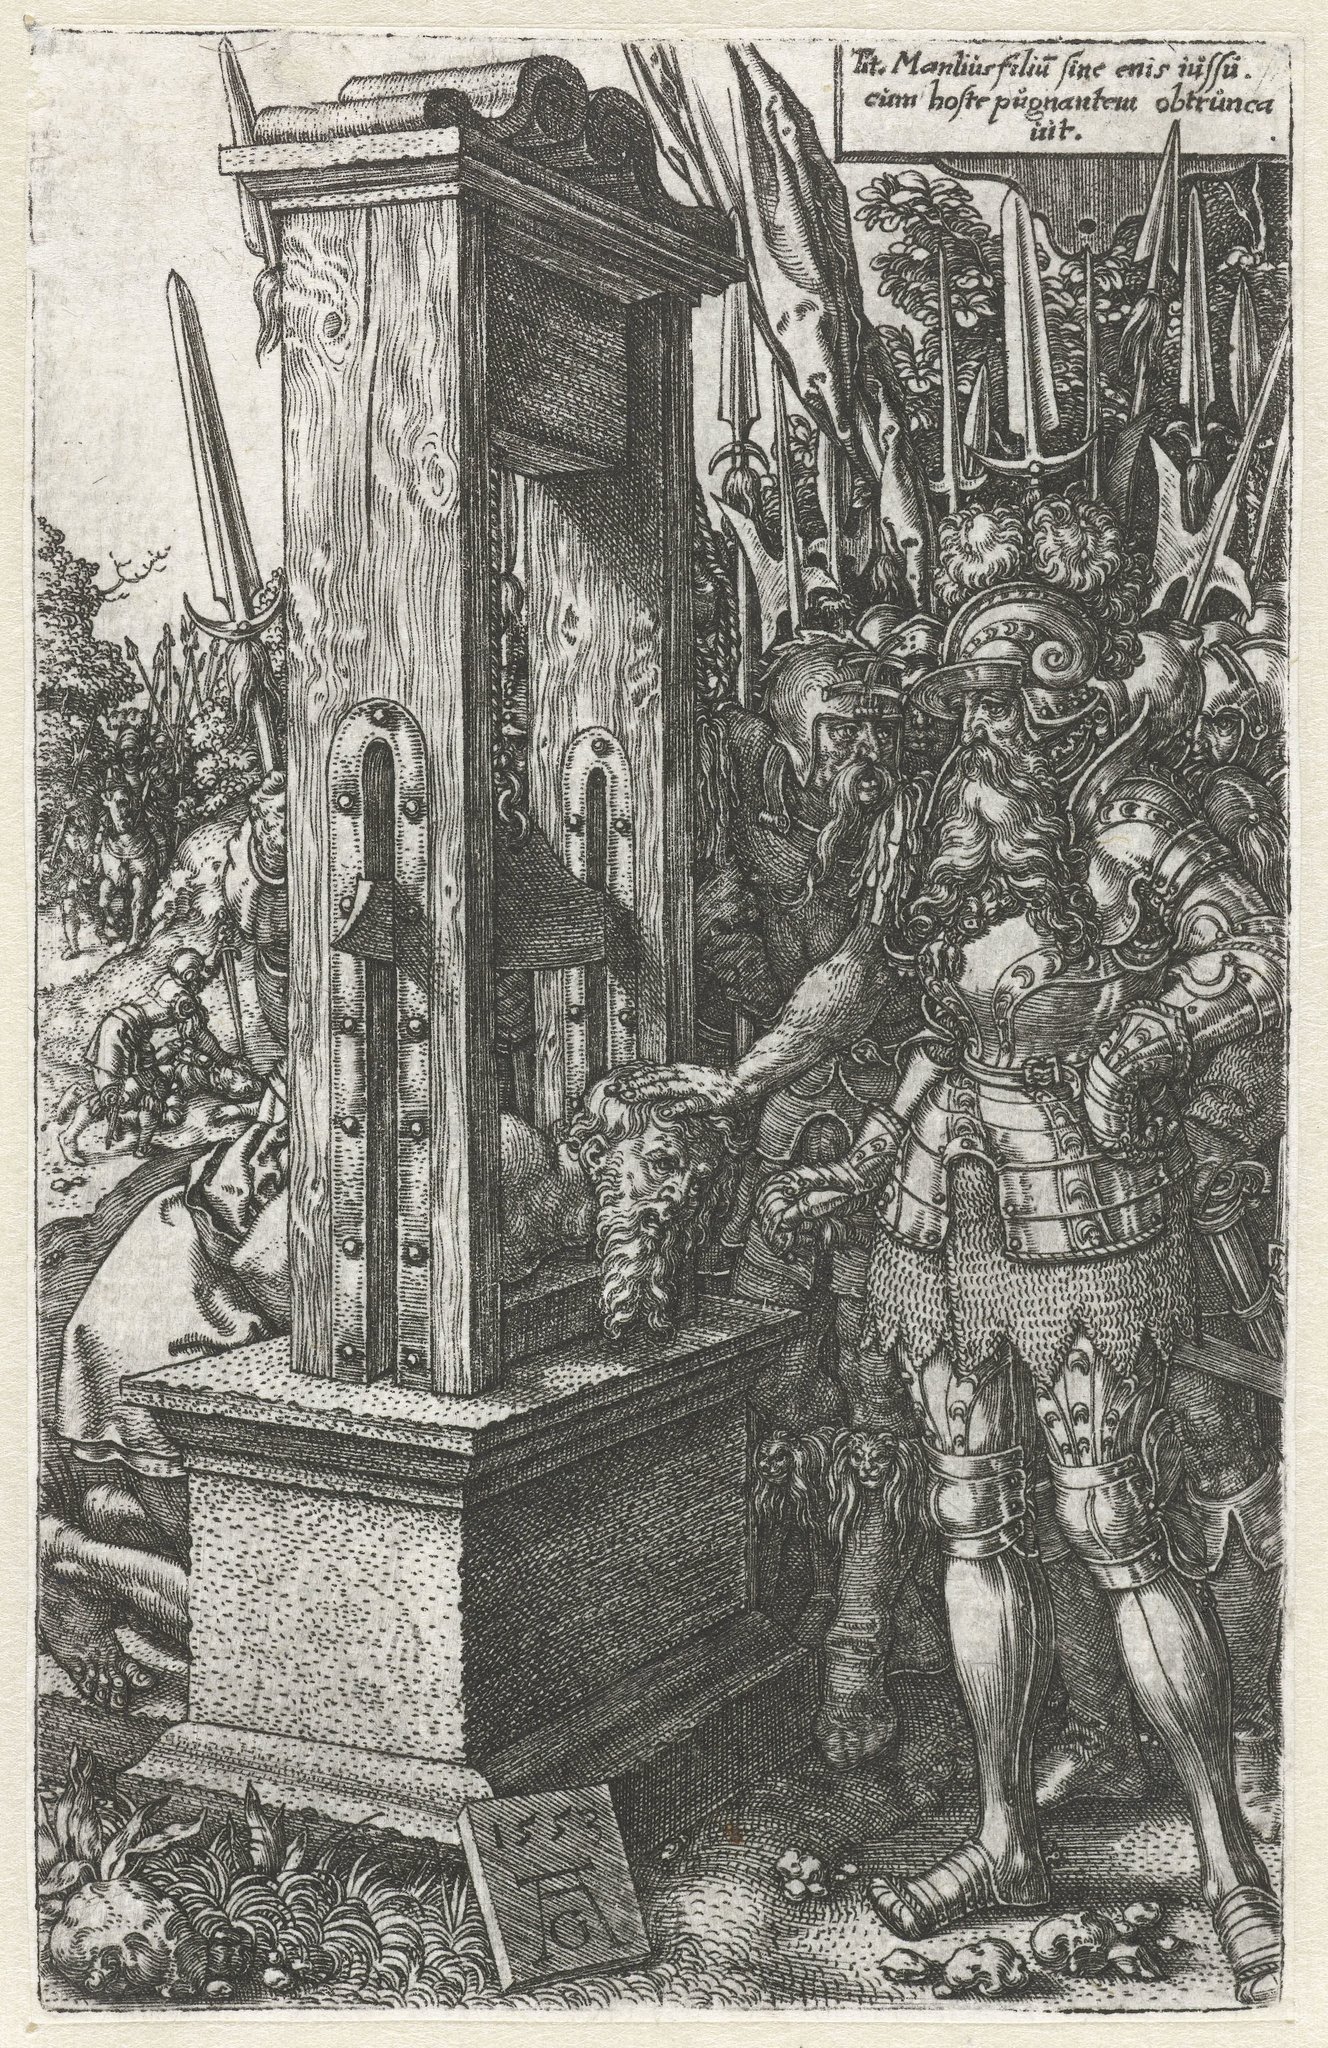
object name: print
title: Titus Manlius Torquatus laat zijn zoon executeren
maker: heinrich aldegrever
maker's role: draughtsman, print maker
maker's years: 1502-1561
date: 1553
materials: paper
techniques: engraving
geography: germany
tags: torquatus has his son beheaded because he has fought an enemy in single combat against the strict orders of his father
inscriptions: date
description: Titus Manlius Torquatus laat zijn zoon onthoofden omdat deze tegen zijn bevelen in is gegaan. Hij staat naast een voorloper van de guillotine en houdt het hoofd van zijn zoon, die eronder ligt, vast. Achter hem staat een groep soldaten. Rechtsboven een drieregelige tekst in het Latijn.